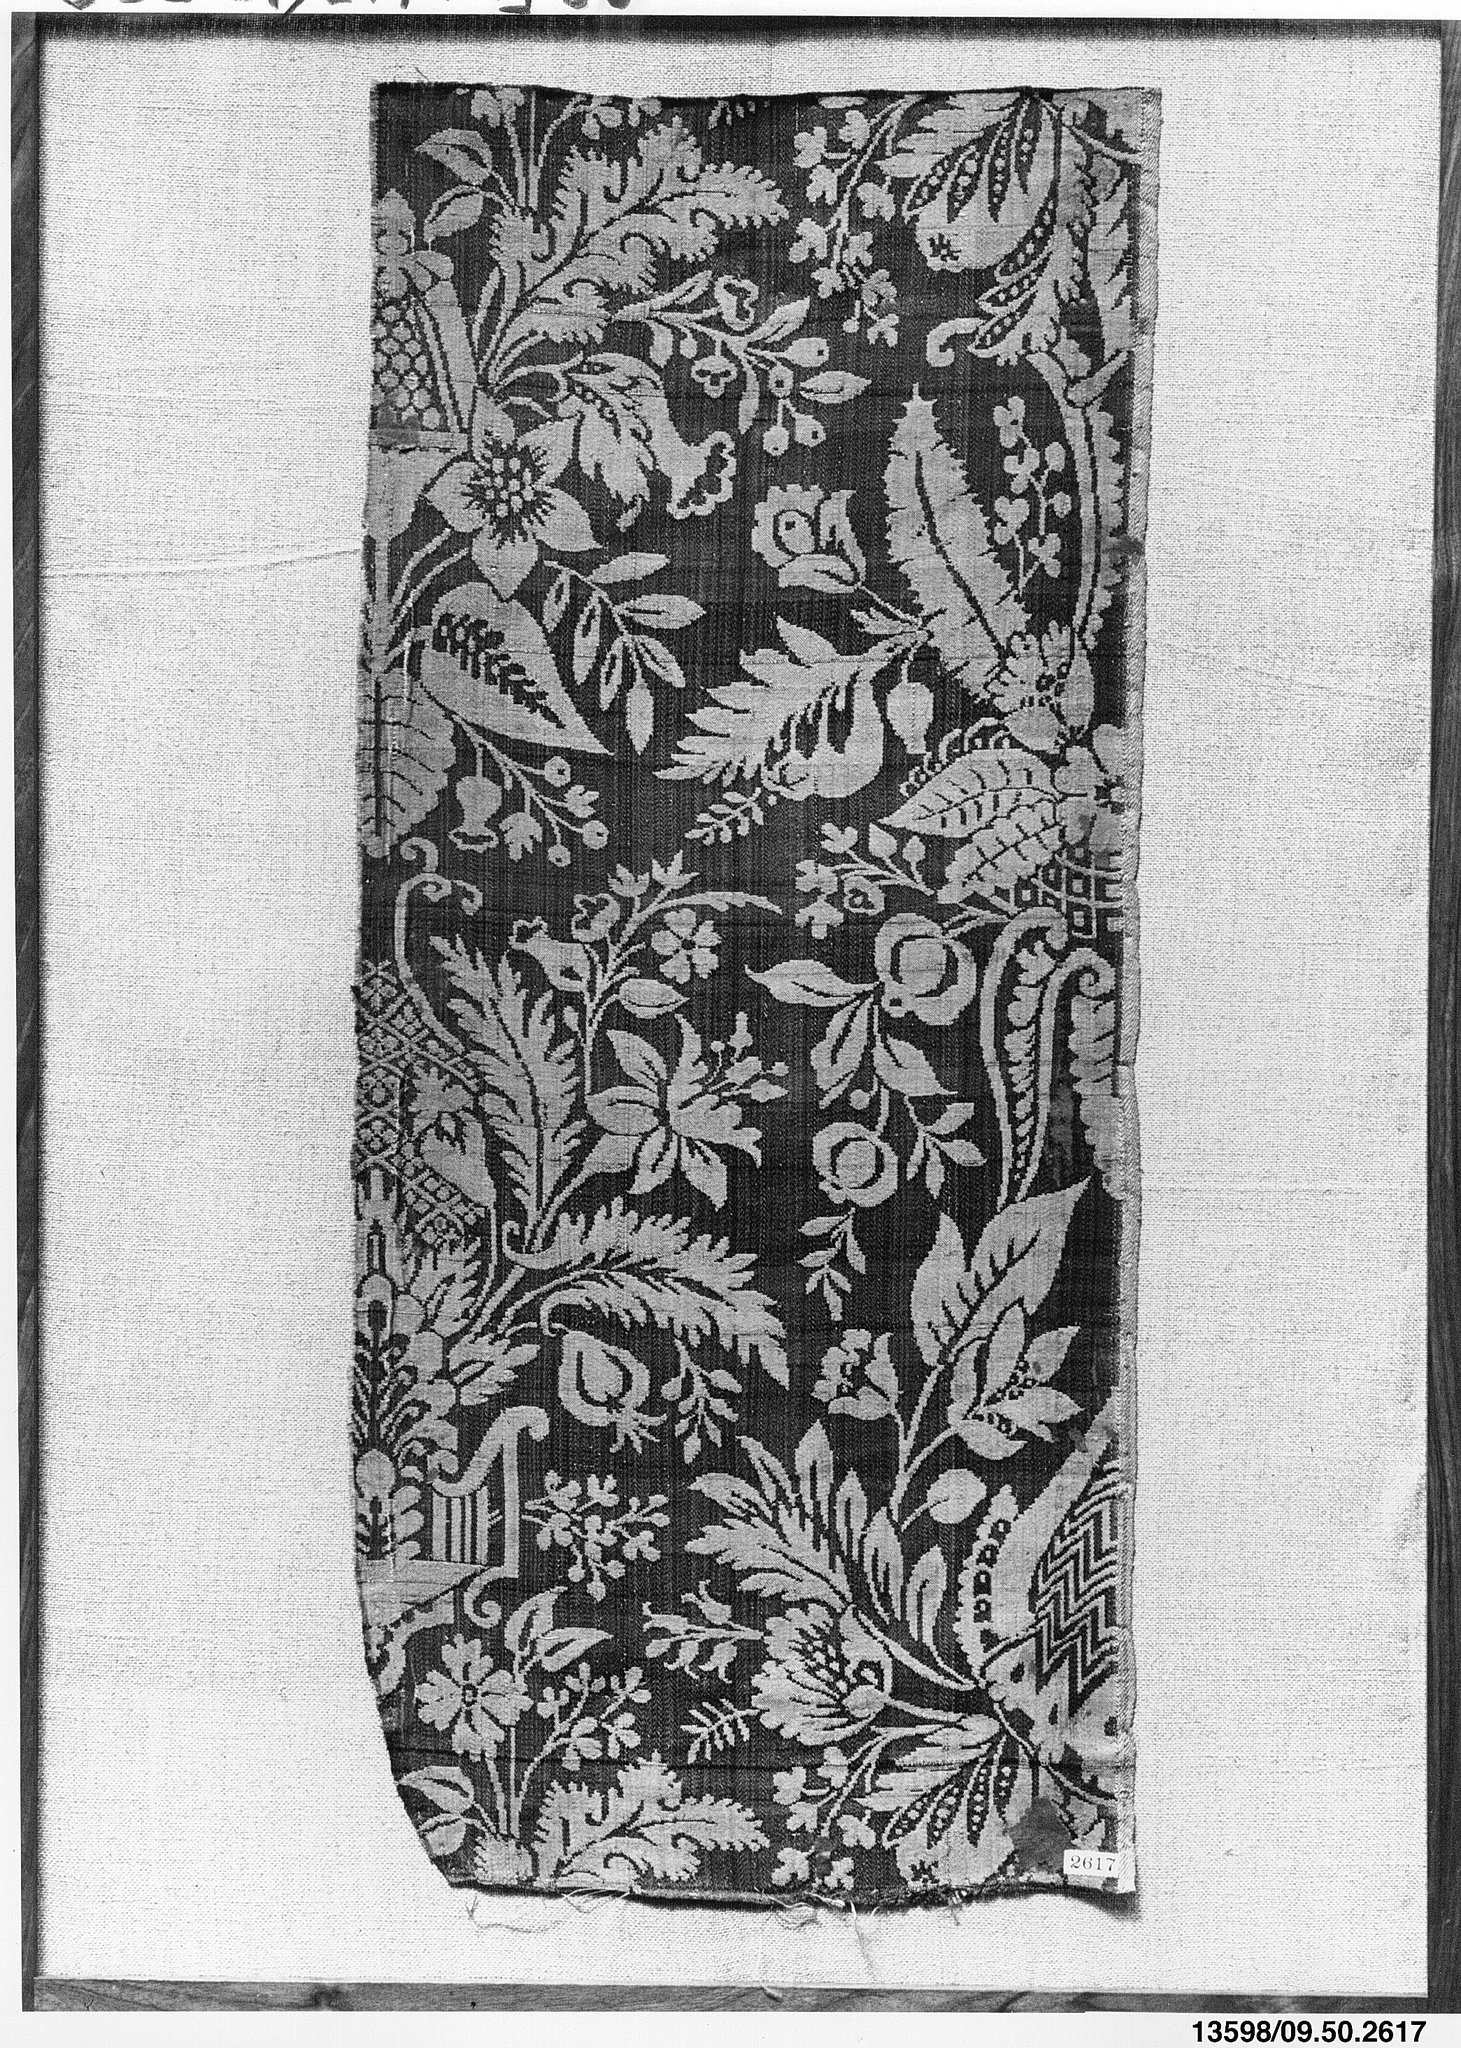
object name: piece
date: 1730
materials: silk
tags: flowers,leaves